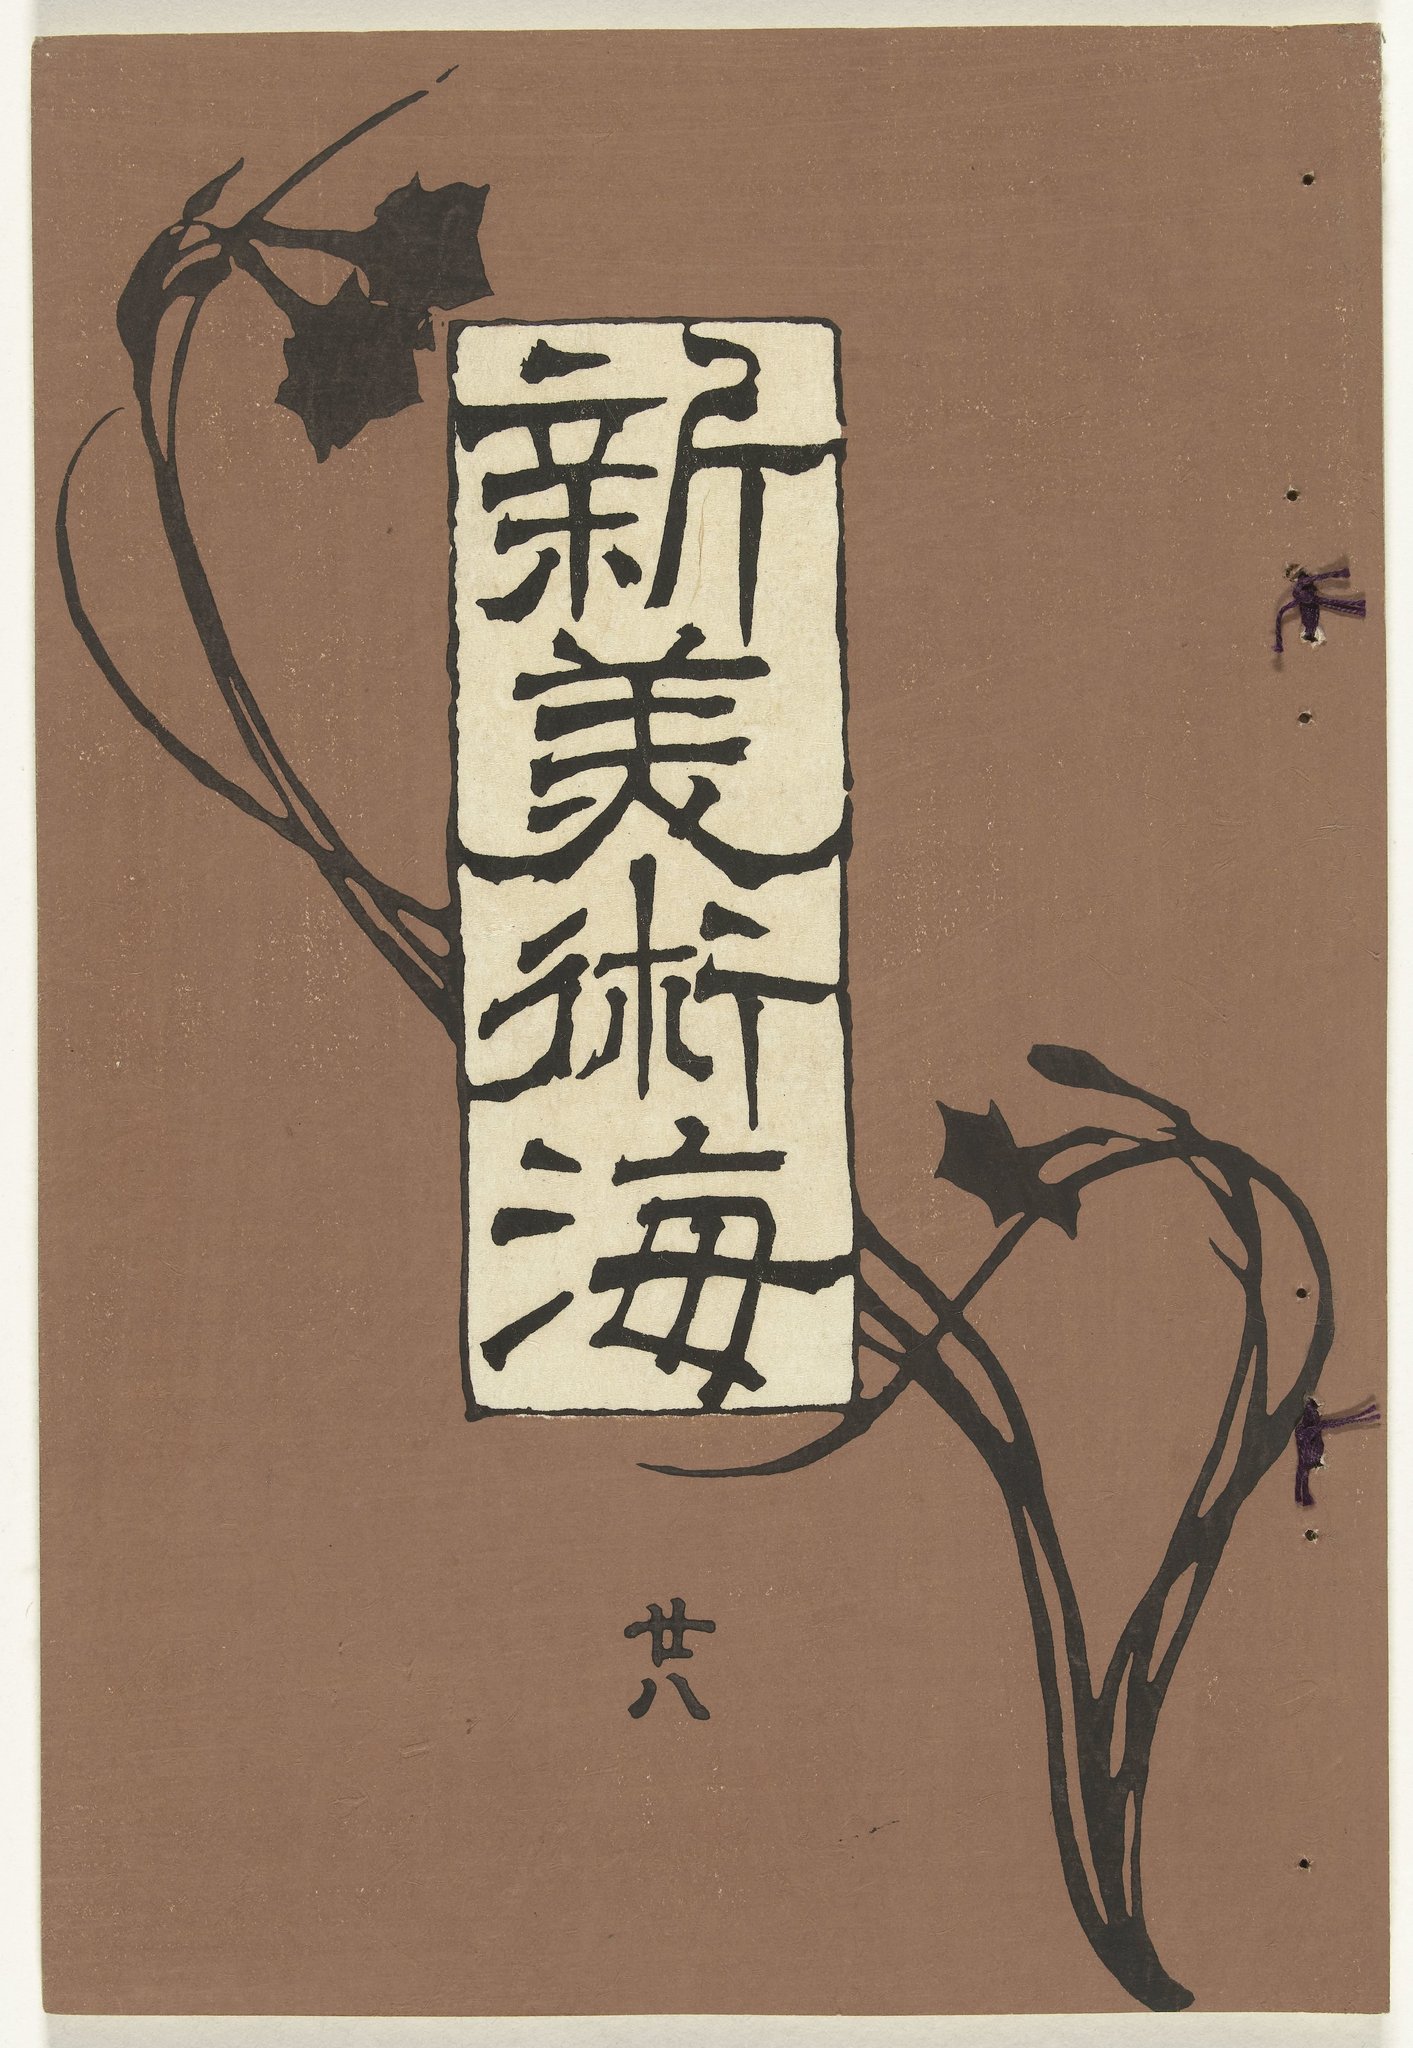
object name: book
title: Nieuwe zee der kunsten - 28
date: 1905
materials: gold powder, paper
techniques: woodcut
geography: kyoto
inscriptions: date